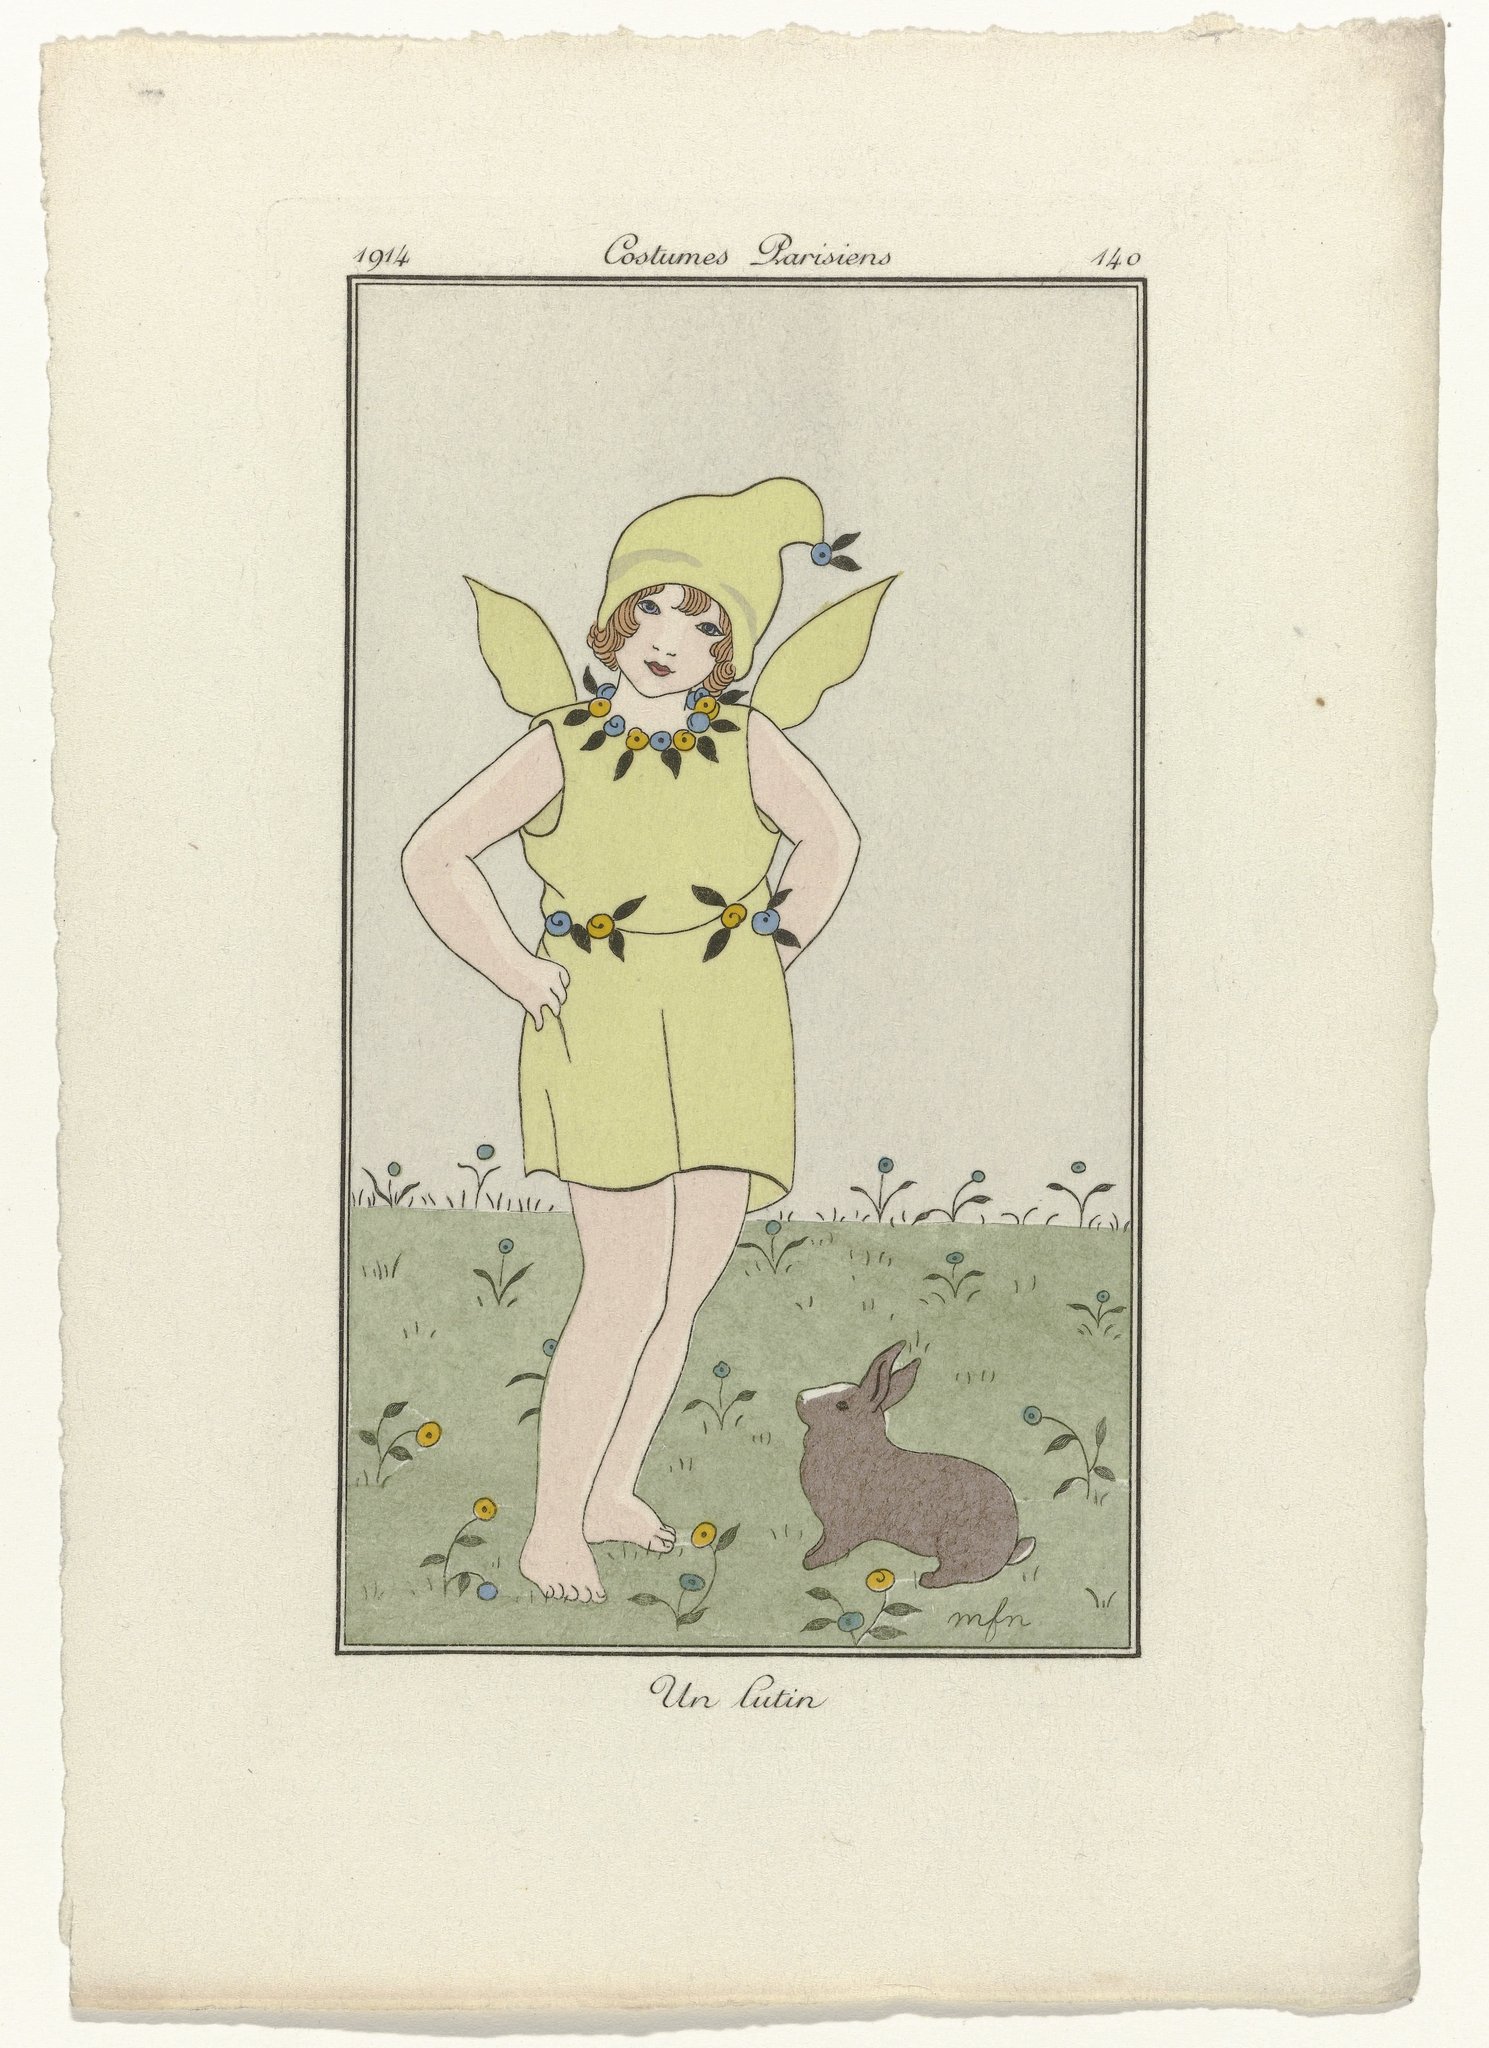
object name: fashion print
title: Journal des Dames et des Modes, Costumes Parisiens, 1914, No. 140 : Un lutin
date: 1914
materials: paper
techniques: engraving, hand coloring, pochoir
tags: head-gear: cap (+ girls' clothes), fashion plates, rodents: rabbit, dress, gown (+ girls' clothes)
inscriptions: title: ‘Costumes Parisiens’, caption: ‘Un lutin’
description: Meisje in elfenpakje: mouwloos jurkje, bij de hals en taille versierd met bloemen en bladeren. Op het hoofd een muts uitlopend in een punt. Naast haar een konijn. Prent uit het modetijdschrift Journal des Dames et des Modes (1912-1914).